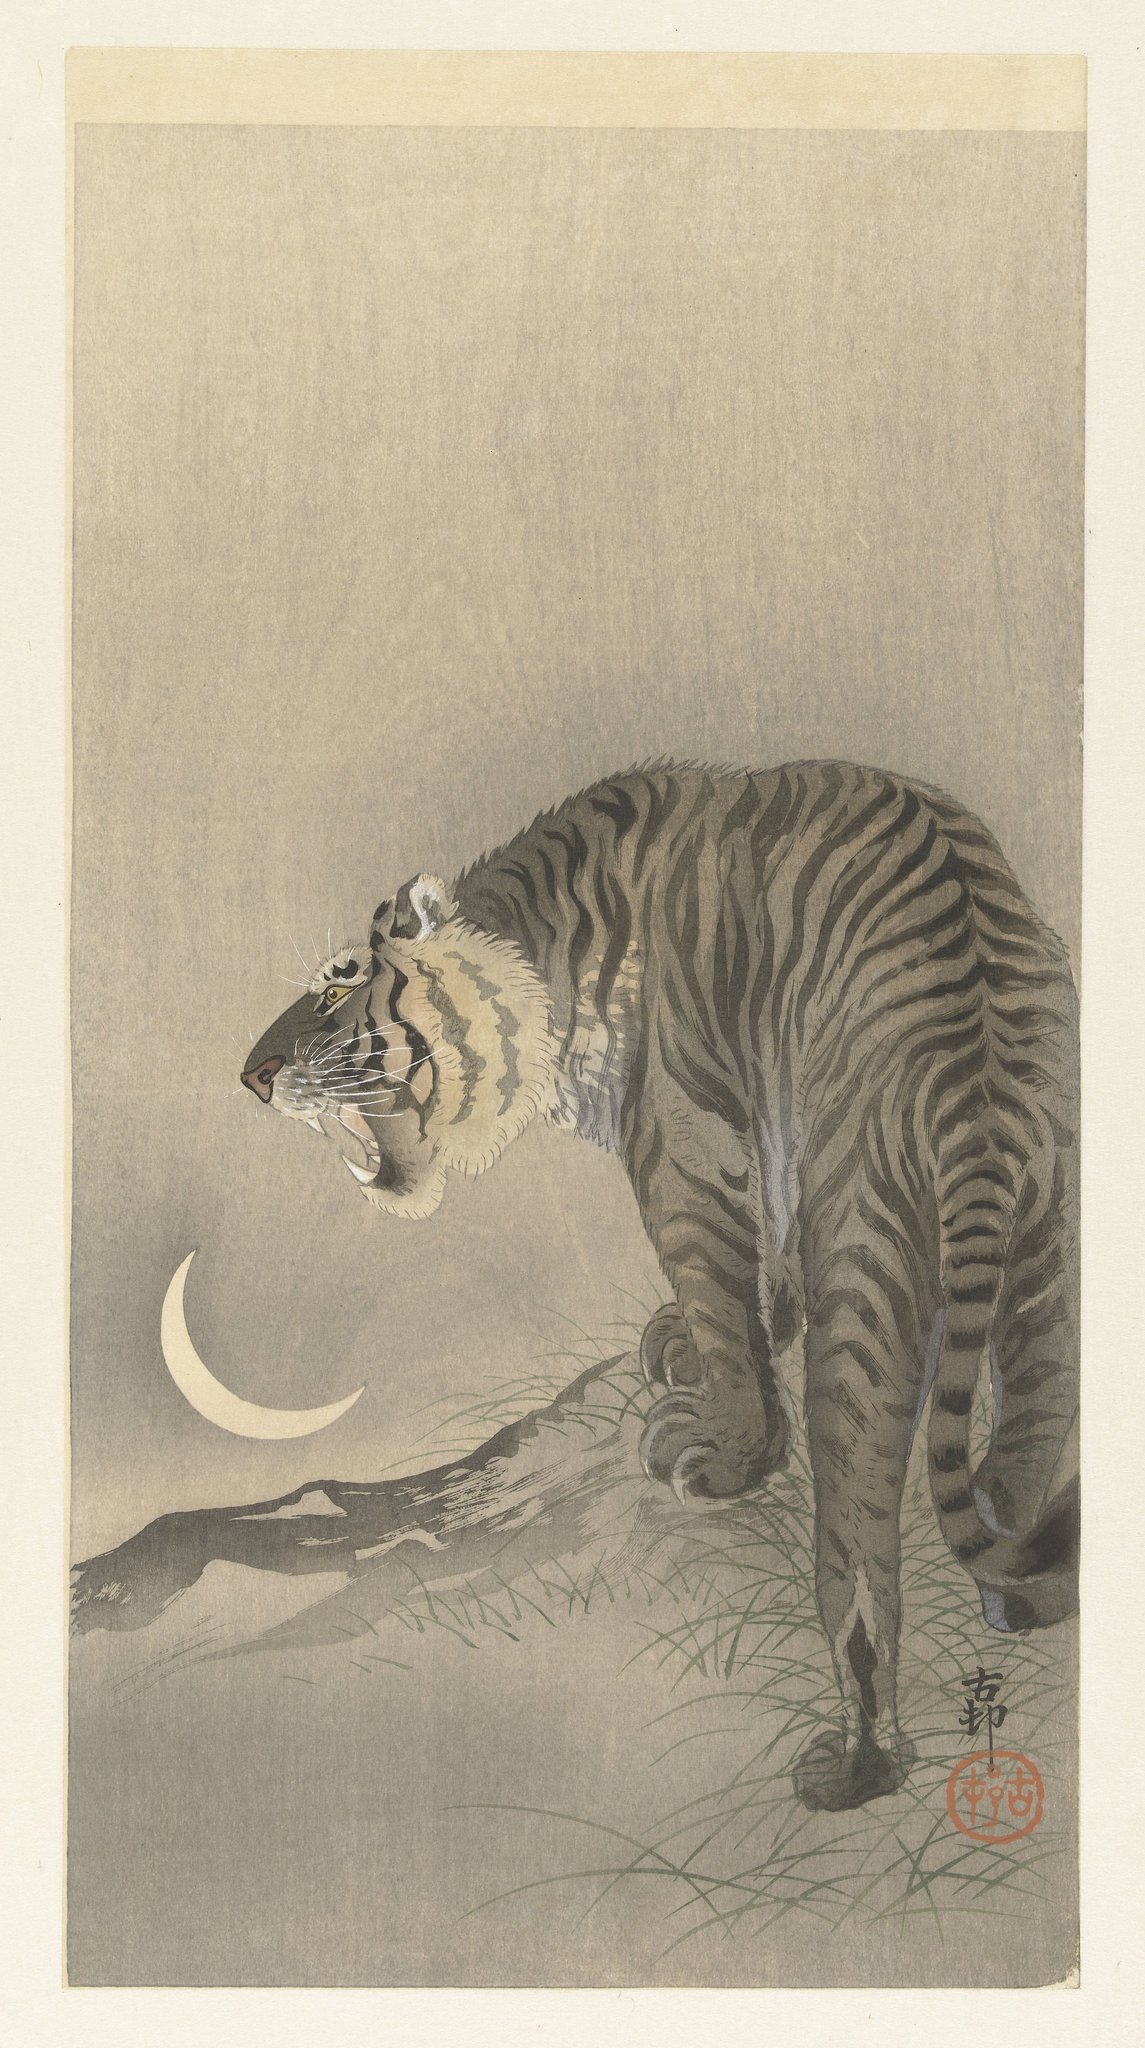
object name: print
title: Brullende tijger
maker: ohara koson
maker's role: print maker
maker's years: 1877-1945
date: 1900-1945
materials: paper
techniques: woodcut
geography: japan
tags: beasts of prey, predatory animals: tiger, moon as celestial body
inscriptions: collector's mark: Lugt 2228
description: Brullende tijger bij sikkelvormige maan.